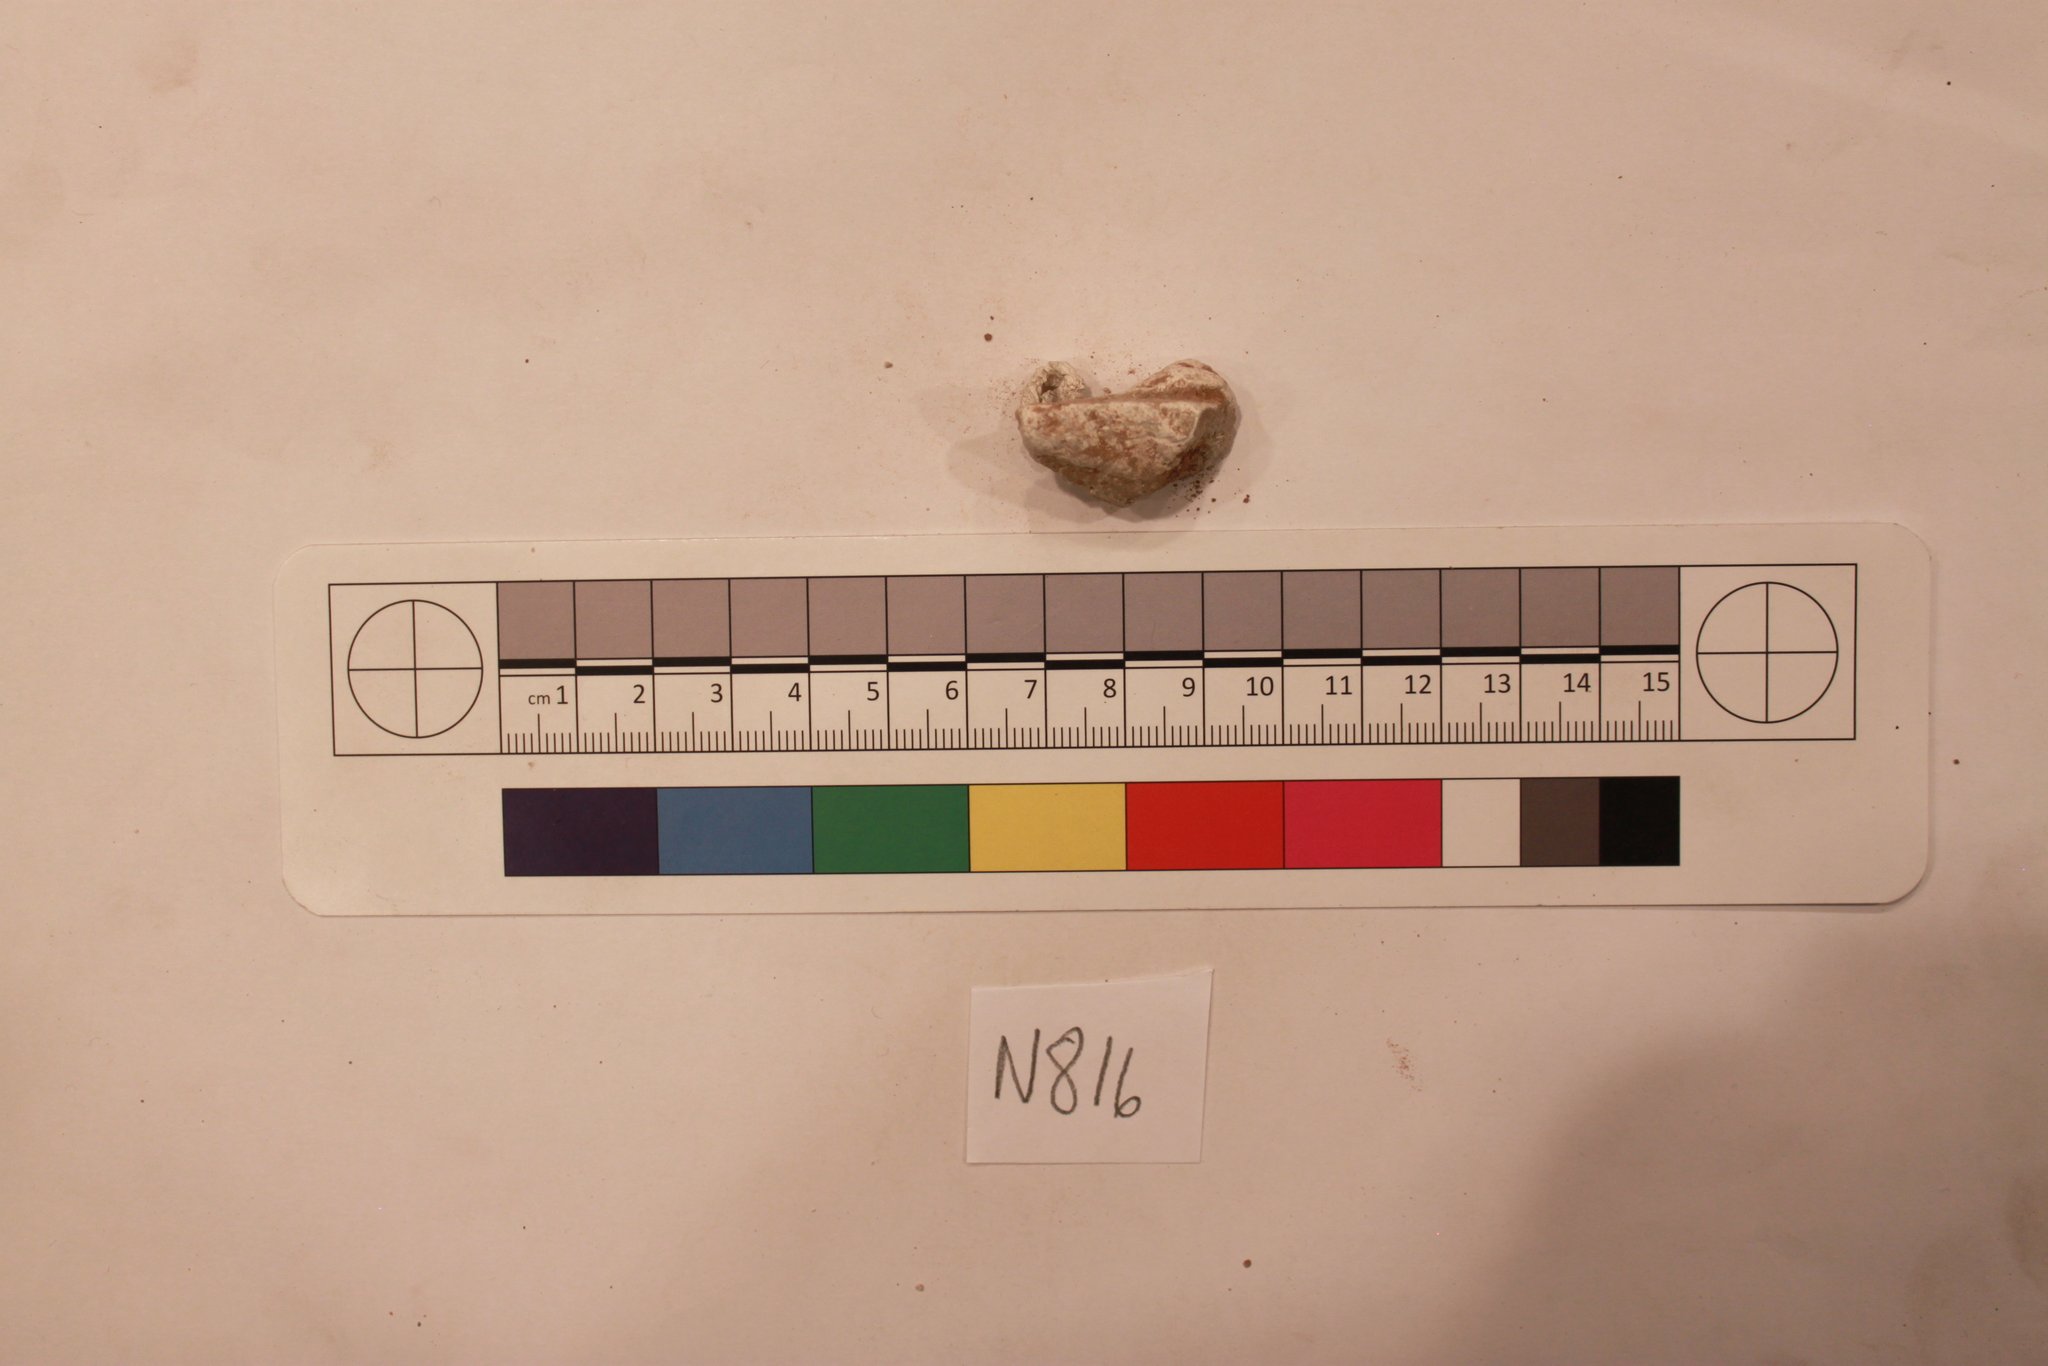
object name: fragment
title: Stucco Fragment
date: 701-1200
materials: plaster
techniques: carving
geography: iran